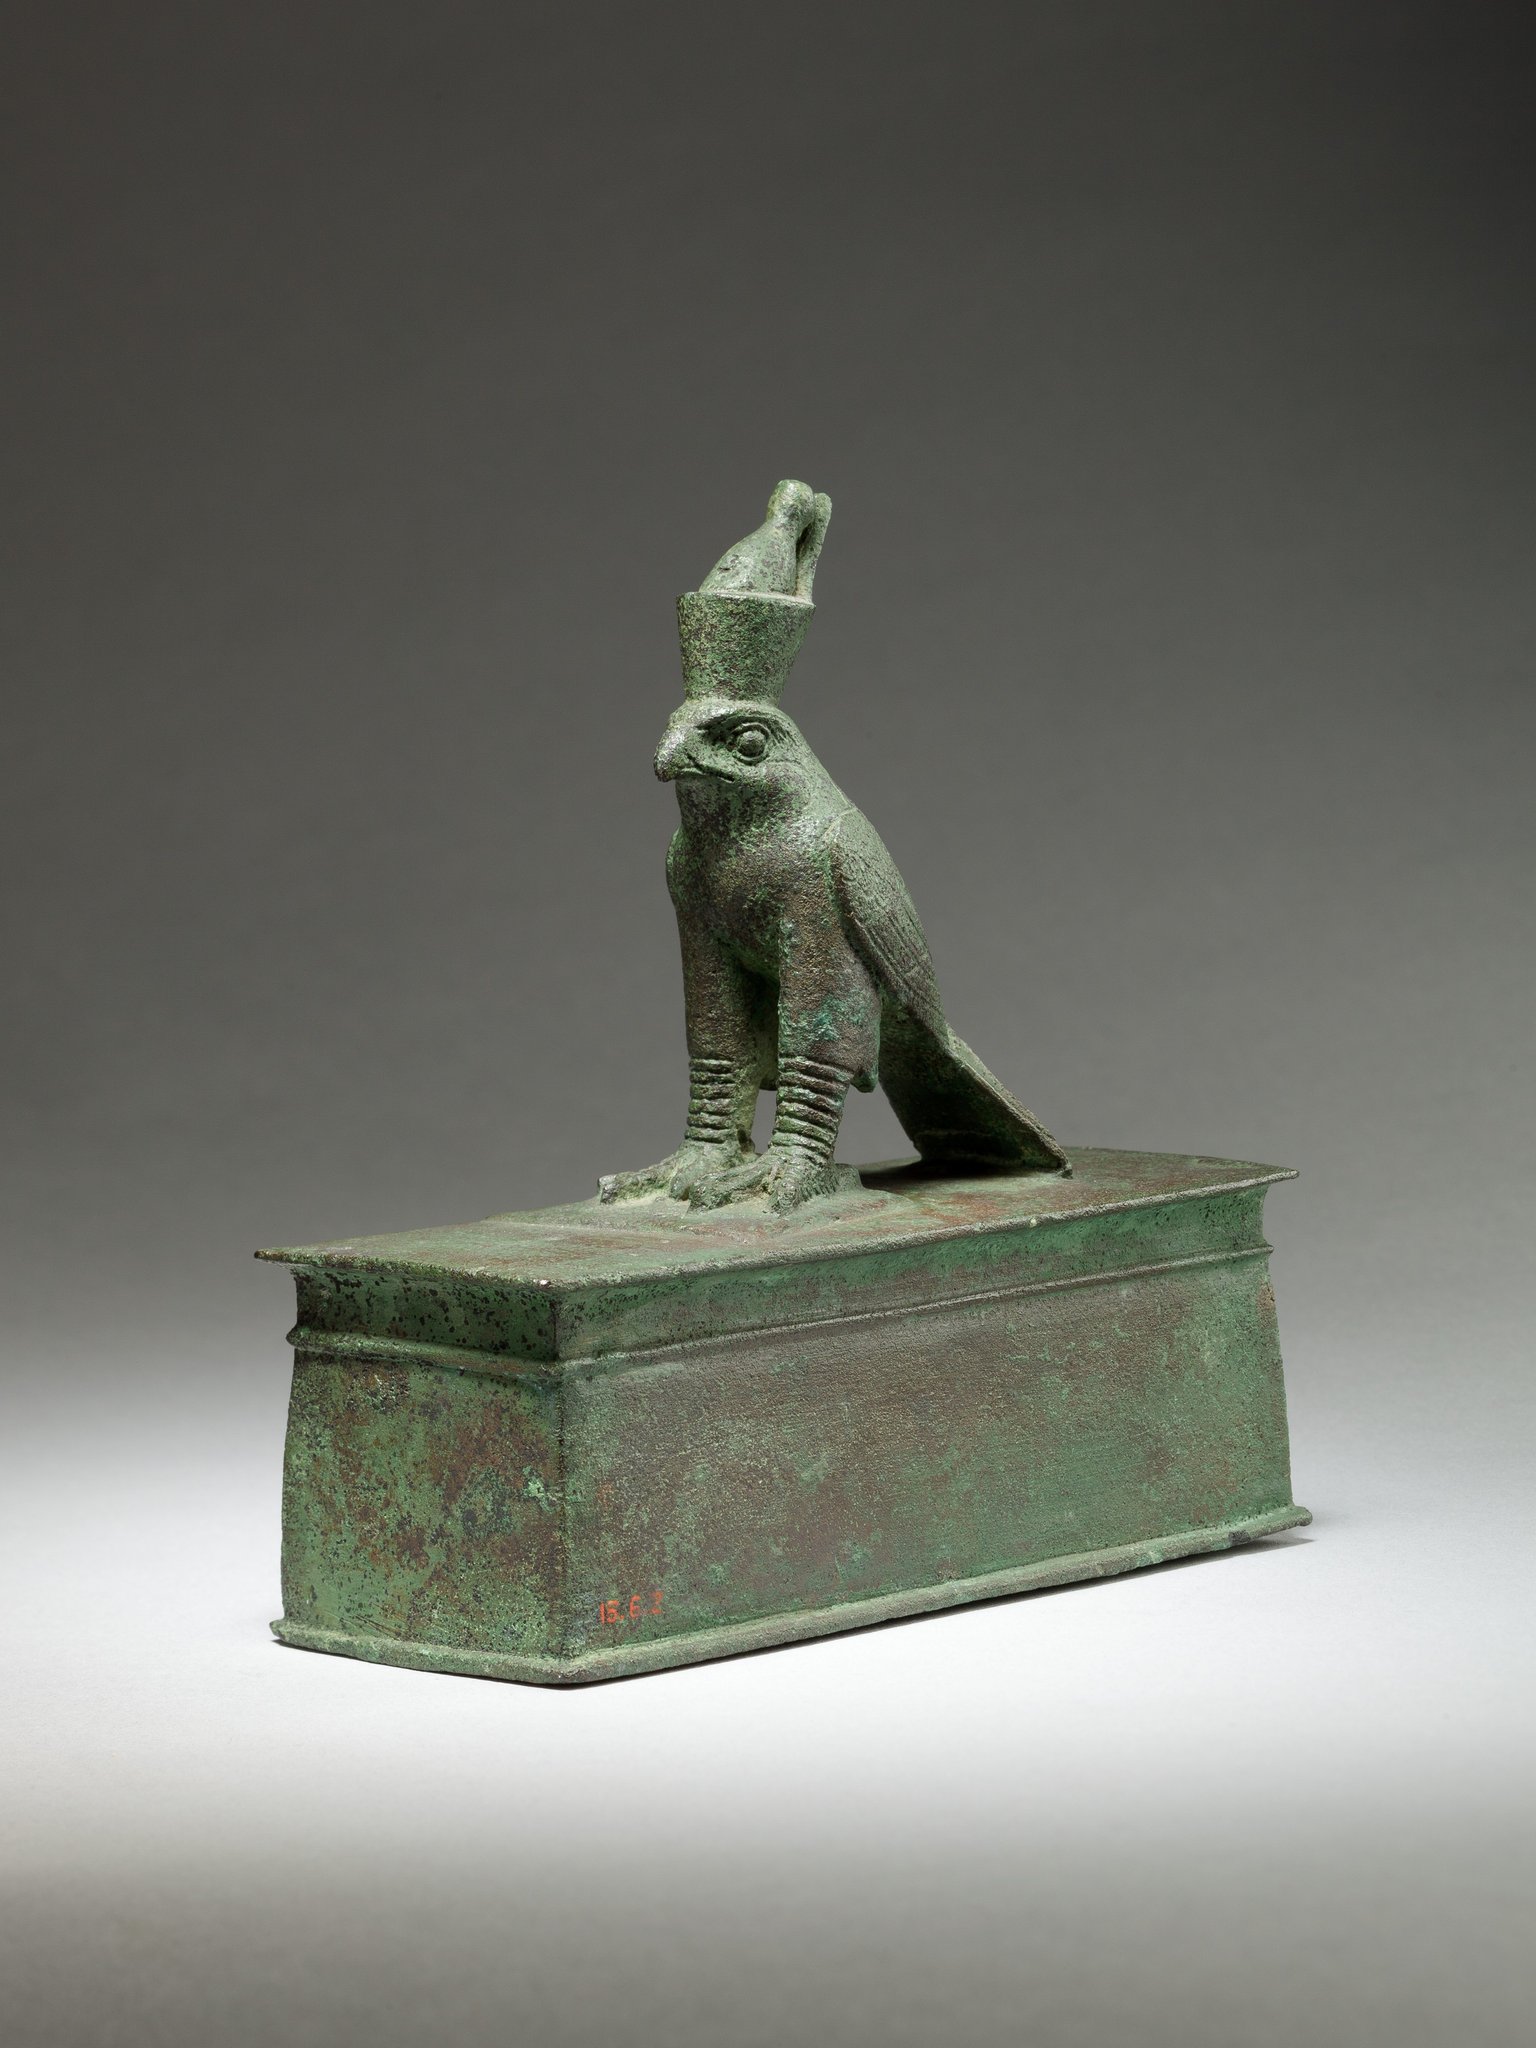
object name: mummy case, falcon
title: Falcon surmounting box for an animal mummy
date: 664-630 BCE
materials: metal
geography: egypt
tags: falcons